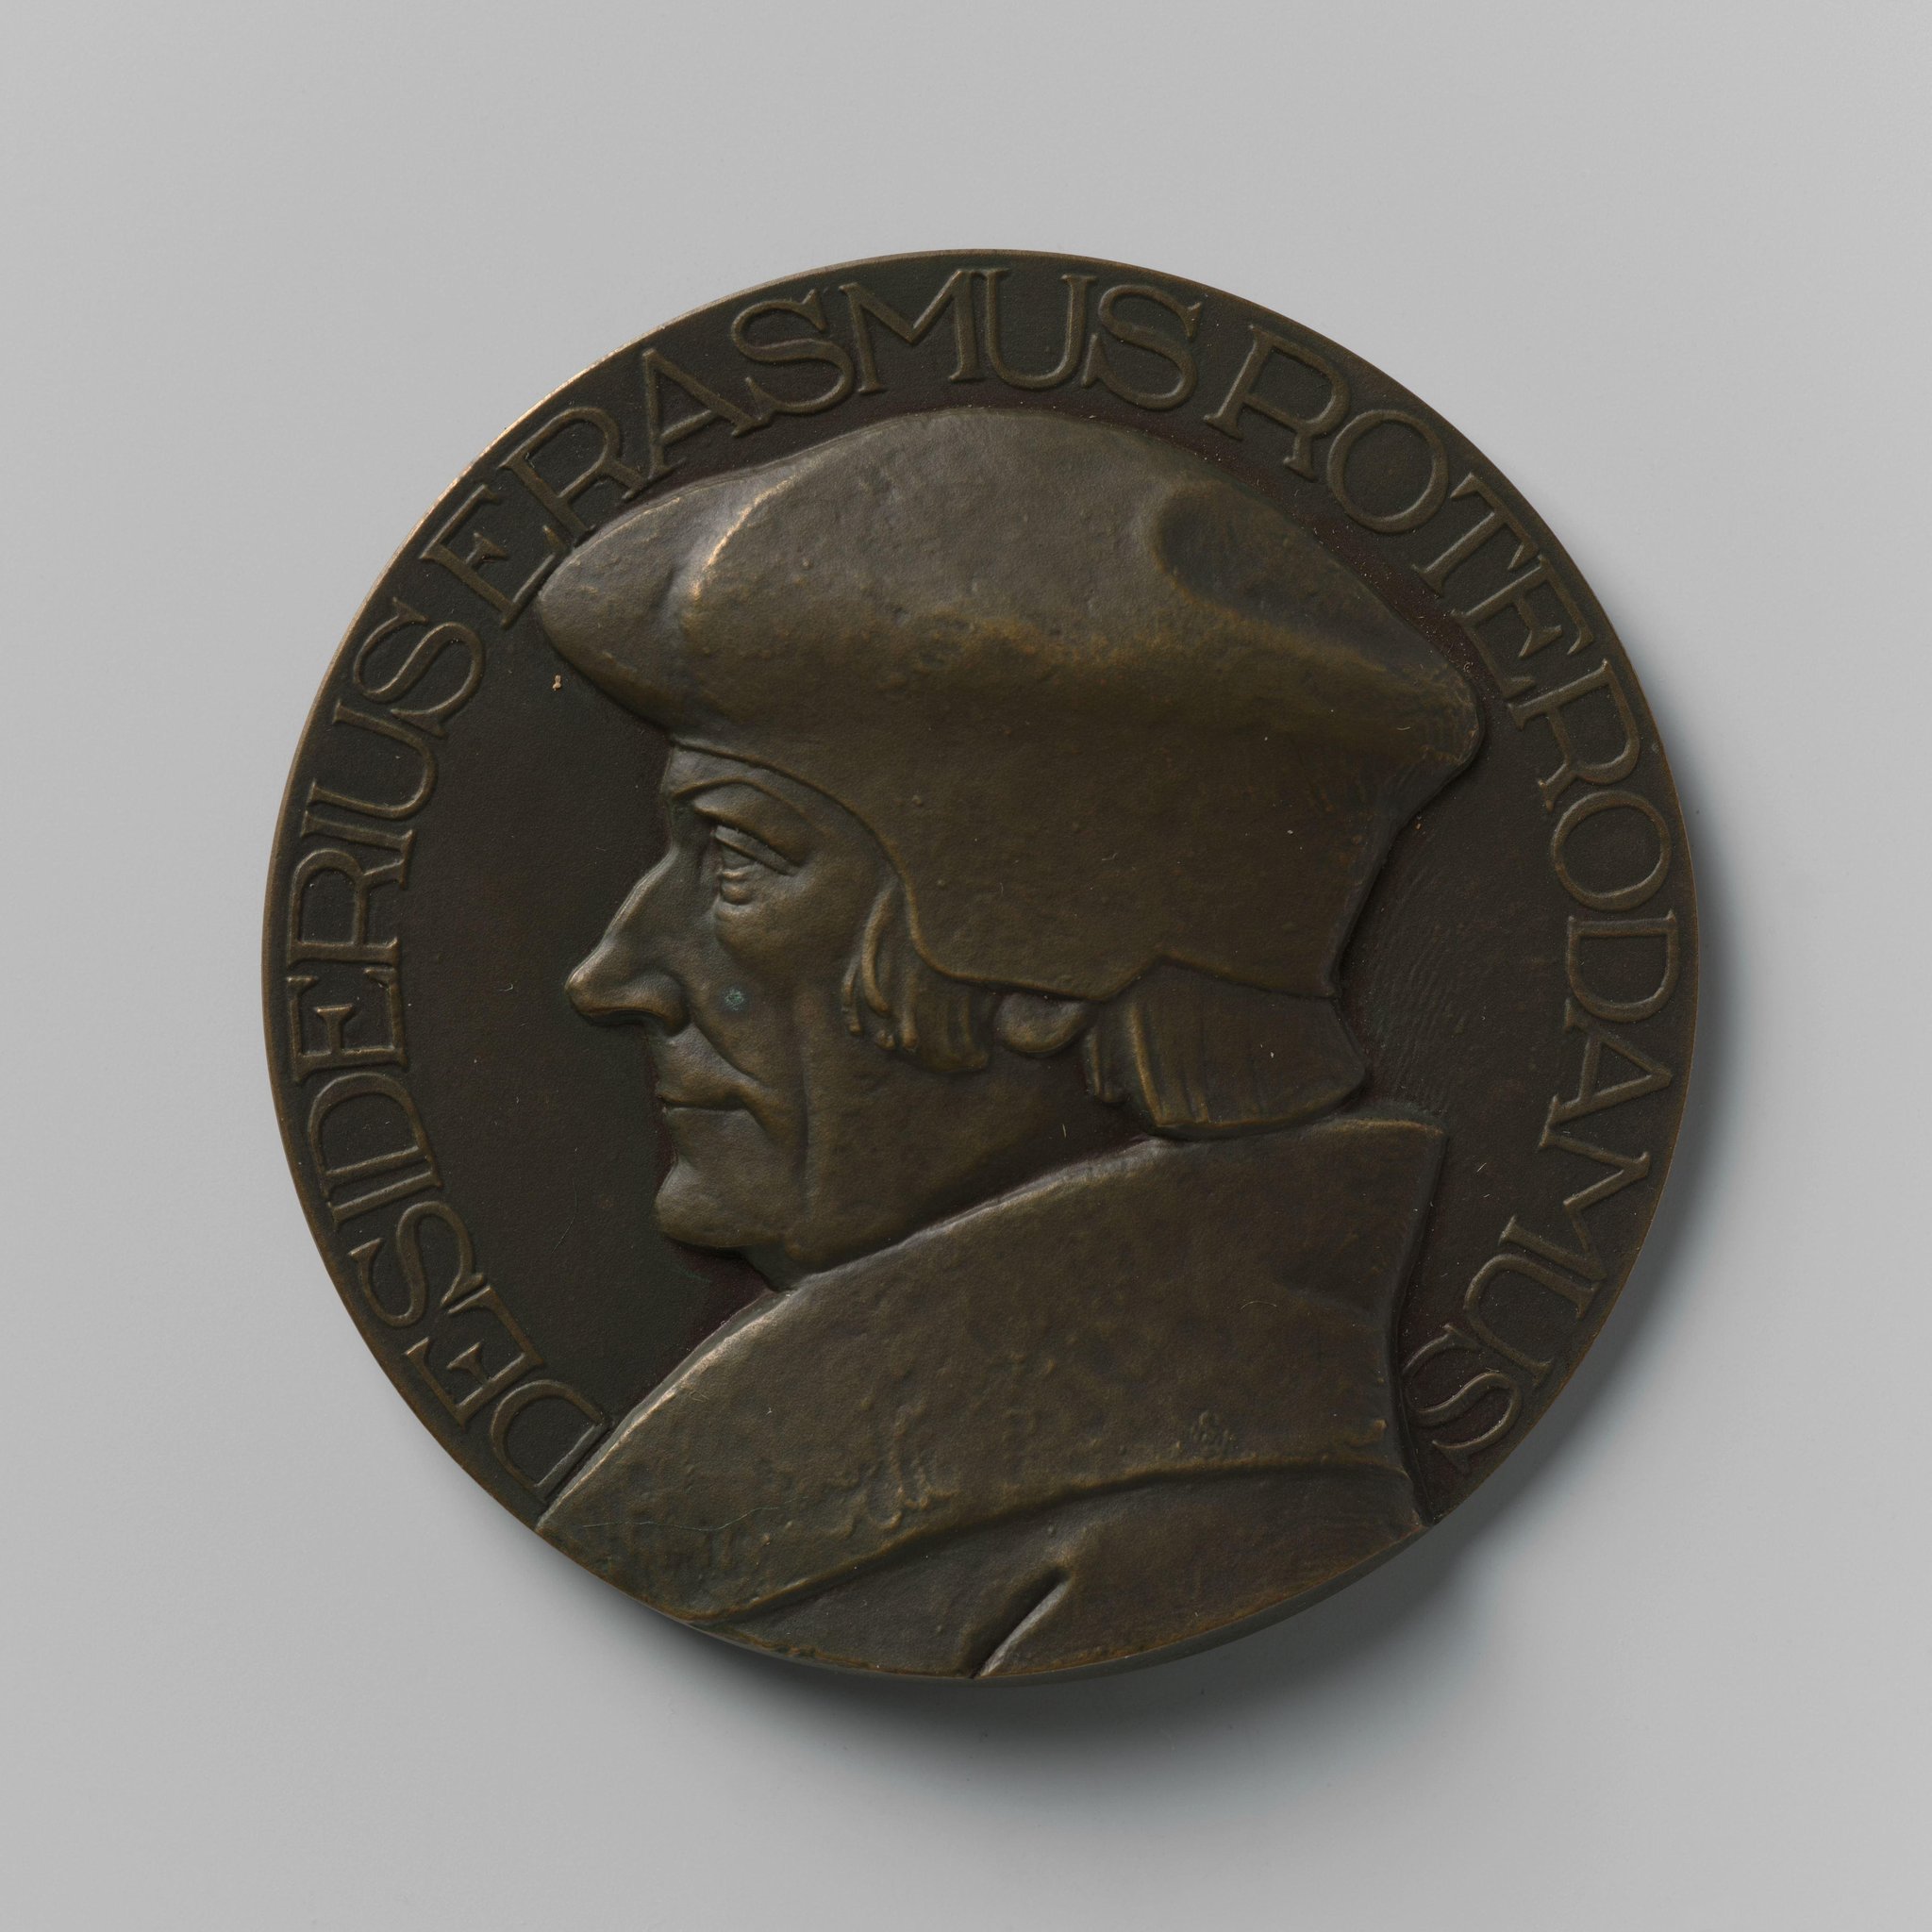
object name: history medal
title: Desiderius Erasmus vierhonderd jaar overleden (Vereniging voor Penningkunst 1936, eerste penning)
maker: bon ingenhousz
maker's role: print maker, sculptor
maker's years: 1881-1953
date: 1936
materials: bronze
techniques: striking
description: Bronzen penning, op de voorzijde het borstbeeld van Erasmus naar links met omschrift, op de keerzijde een aanziende uil met zotskap tussen twee jaartallen, met verklaring.